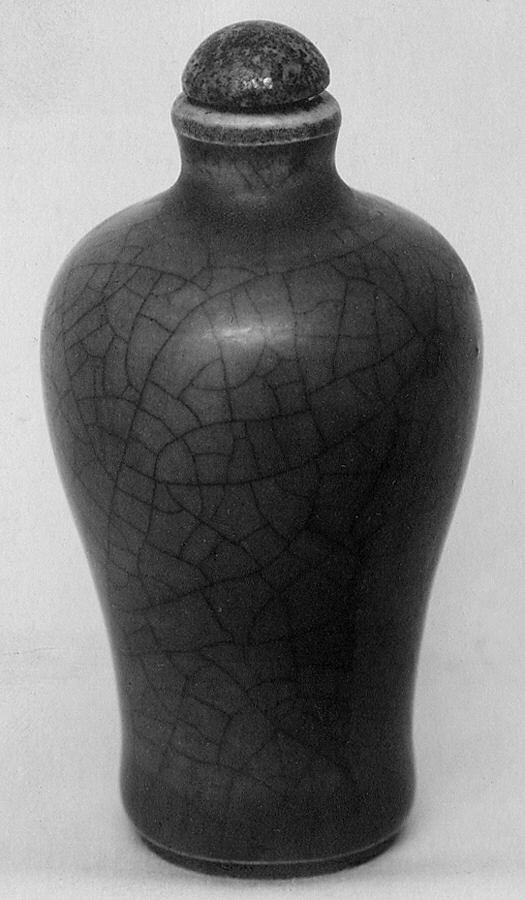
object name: vase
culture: chinese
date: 1867-1900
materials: porcelain